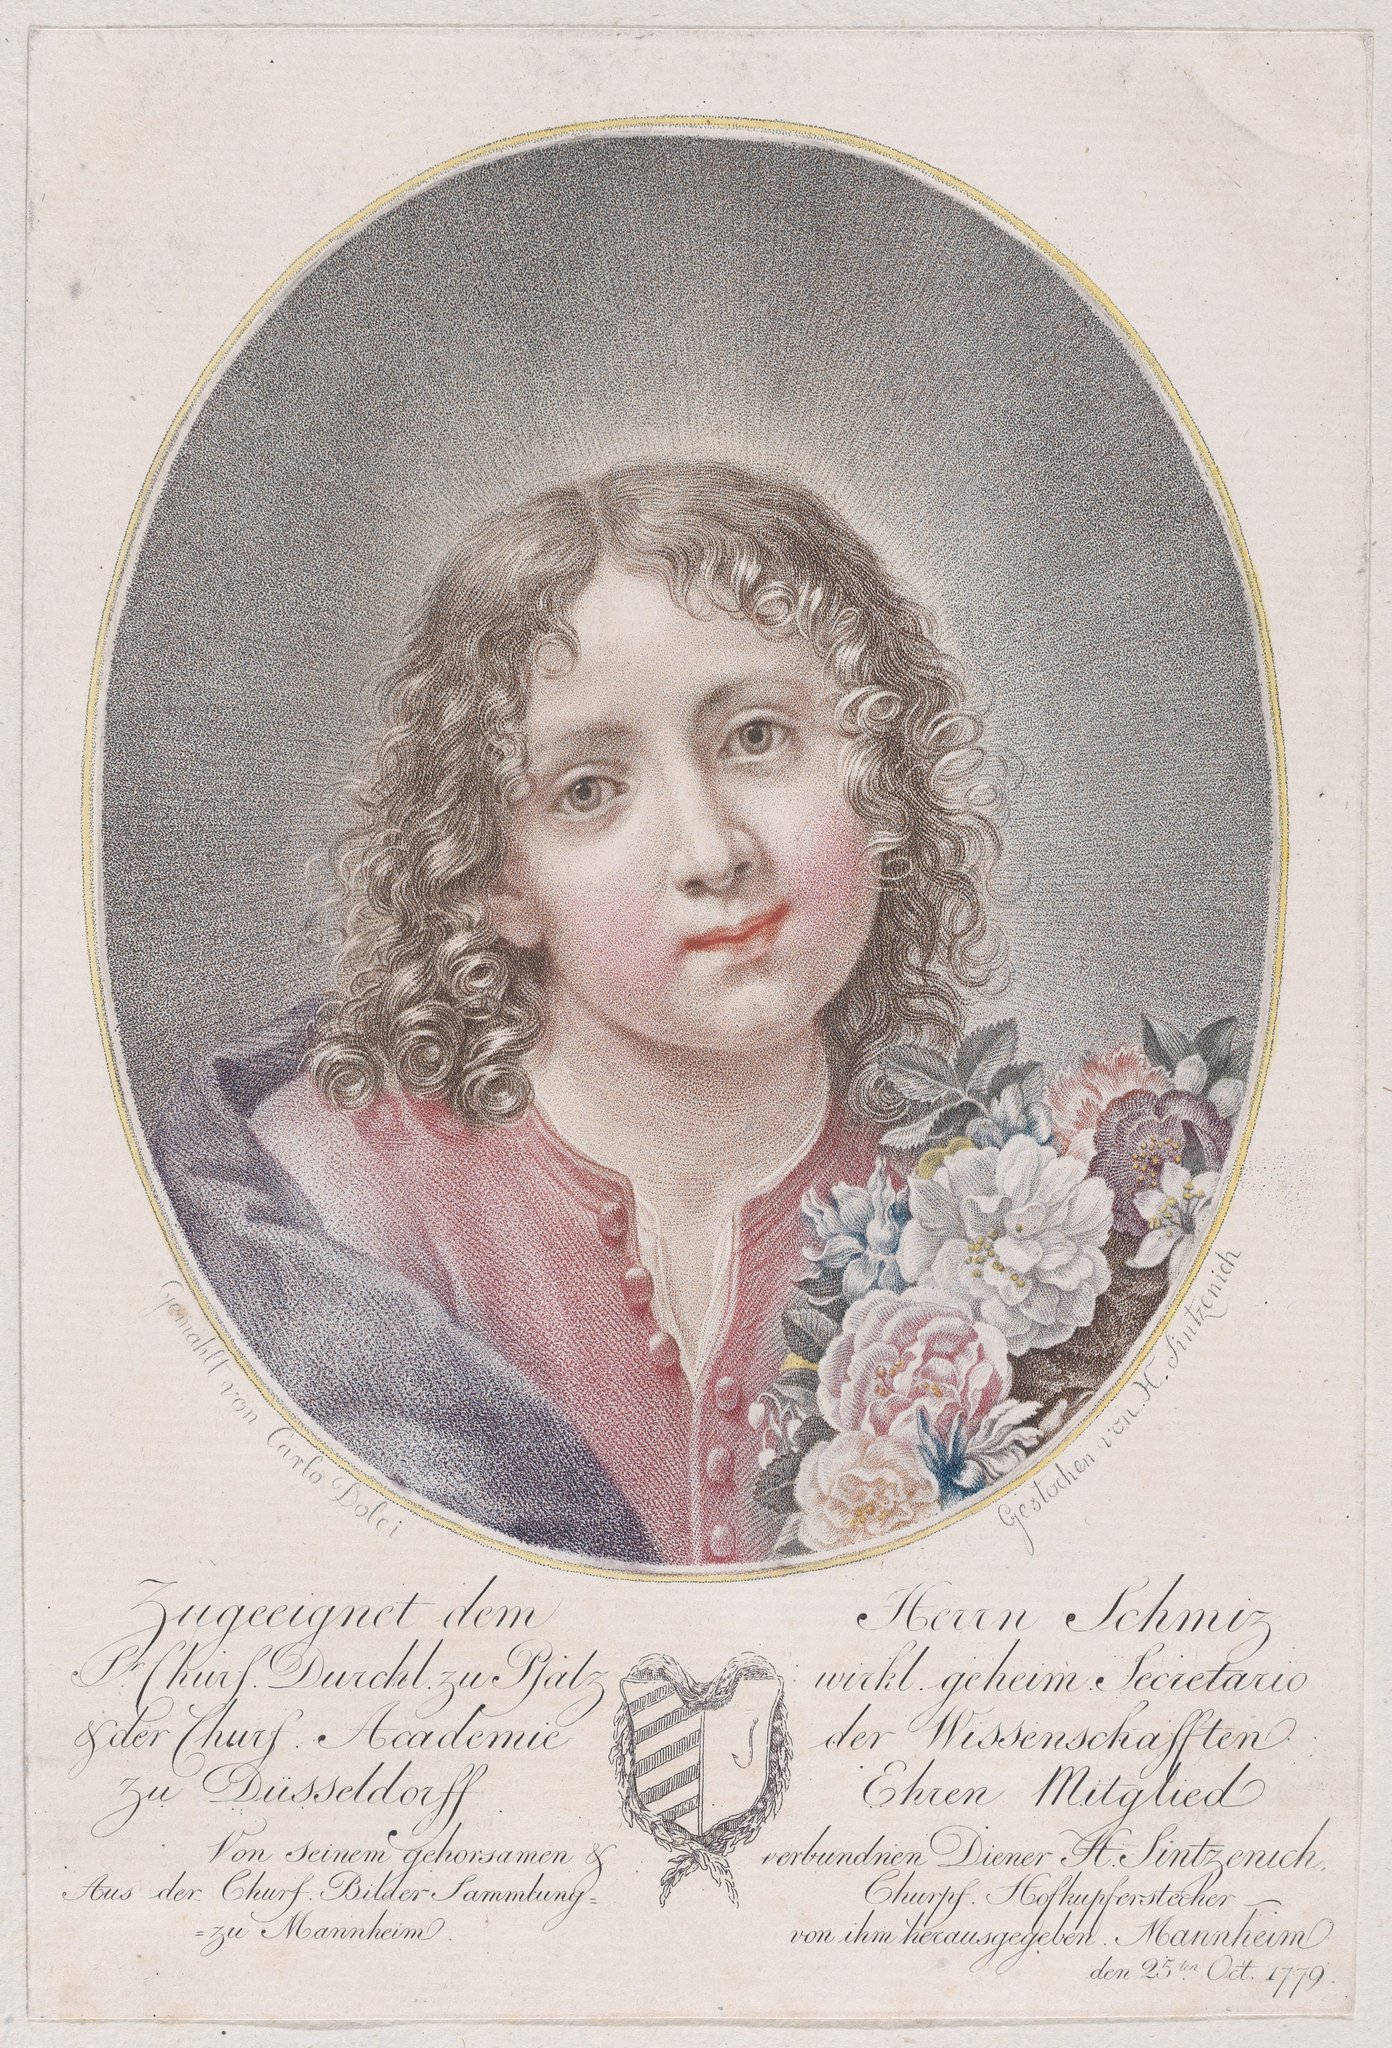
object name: print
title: Head of the young Christ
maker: heinrich sintzenich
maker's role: artist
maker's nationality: german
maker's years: 1752-1812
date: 1779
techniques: etching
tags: christ